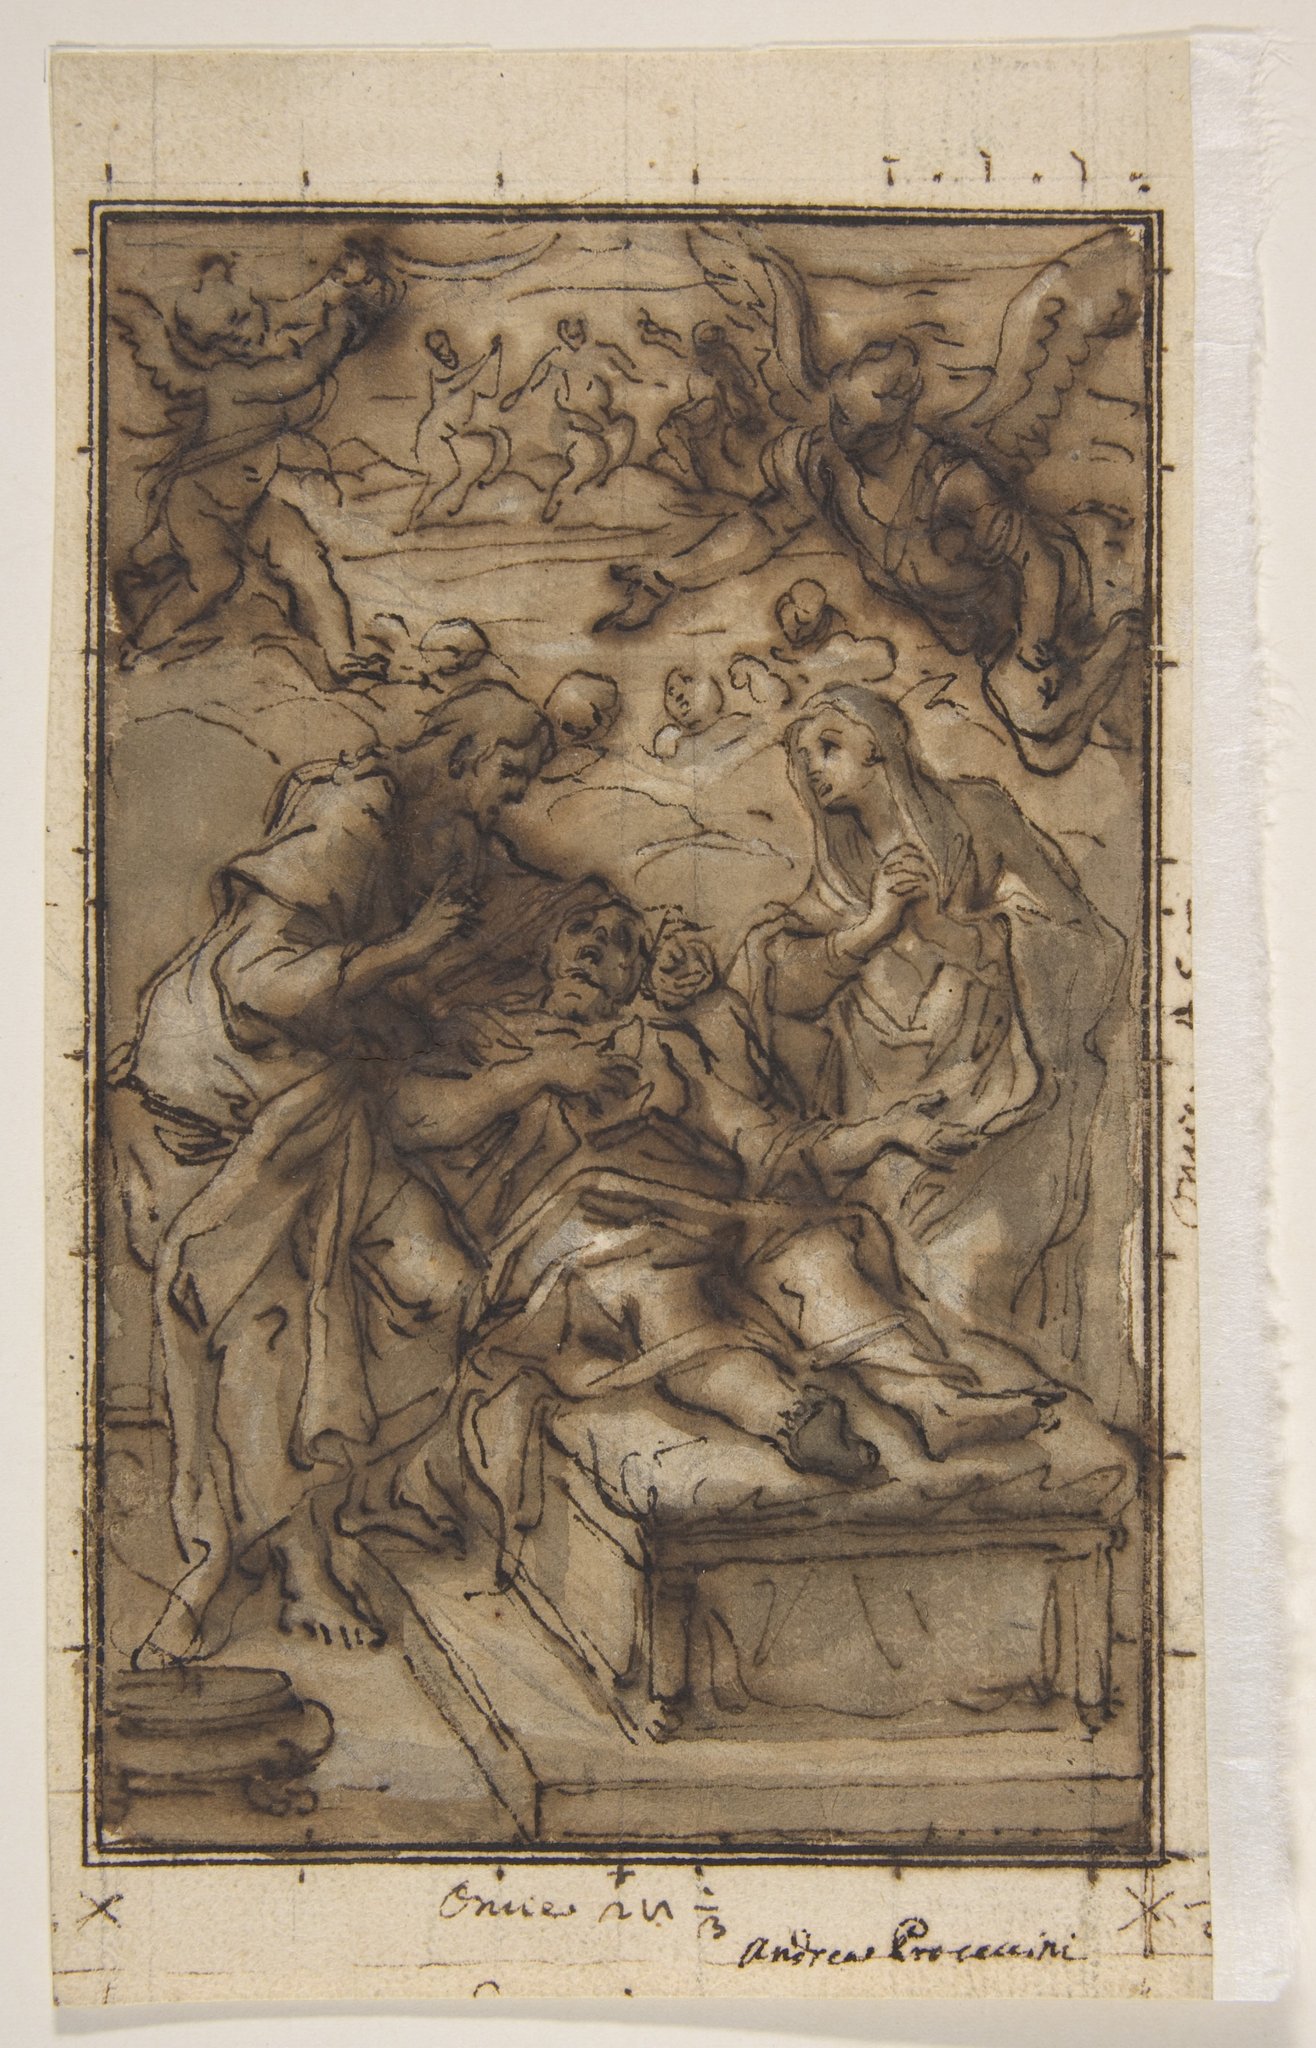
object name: drawing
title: The Death of Saint Joseph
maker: niccolò ricciolini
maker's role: artist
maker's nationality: italian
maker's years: 1687-1772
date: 1739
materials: charcoal, ink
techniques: brush, pen, drawing, wash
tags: women,angels,saint joseph,death